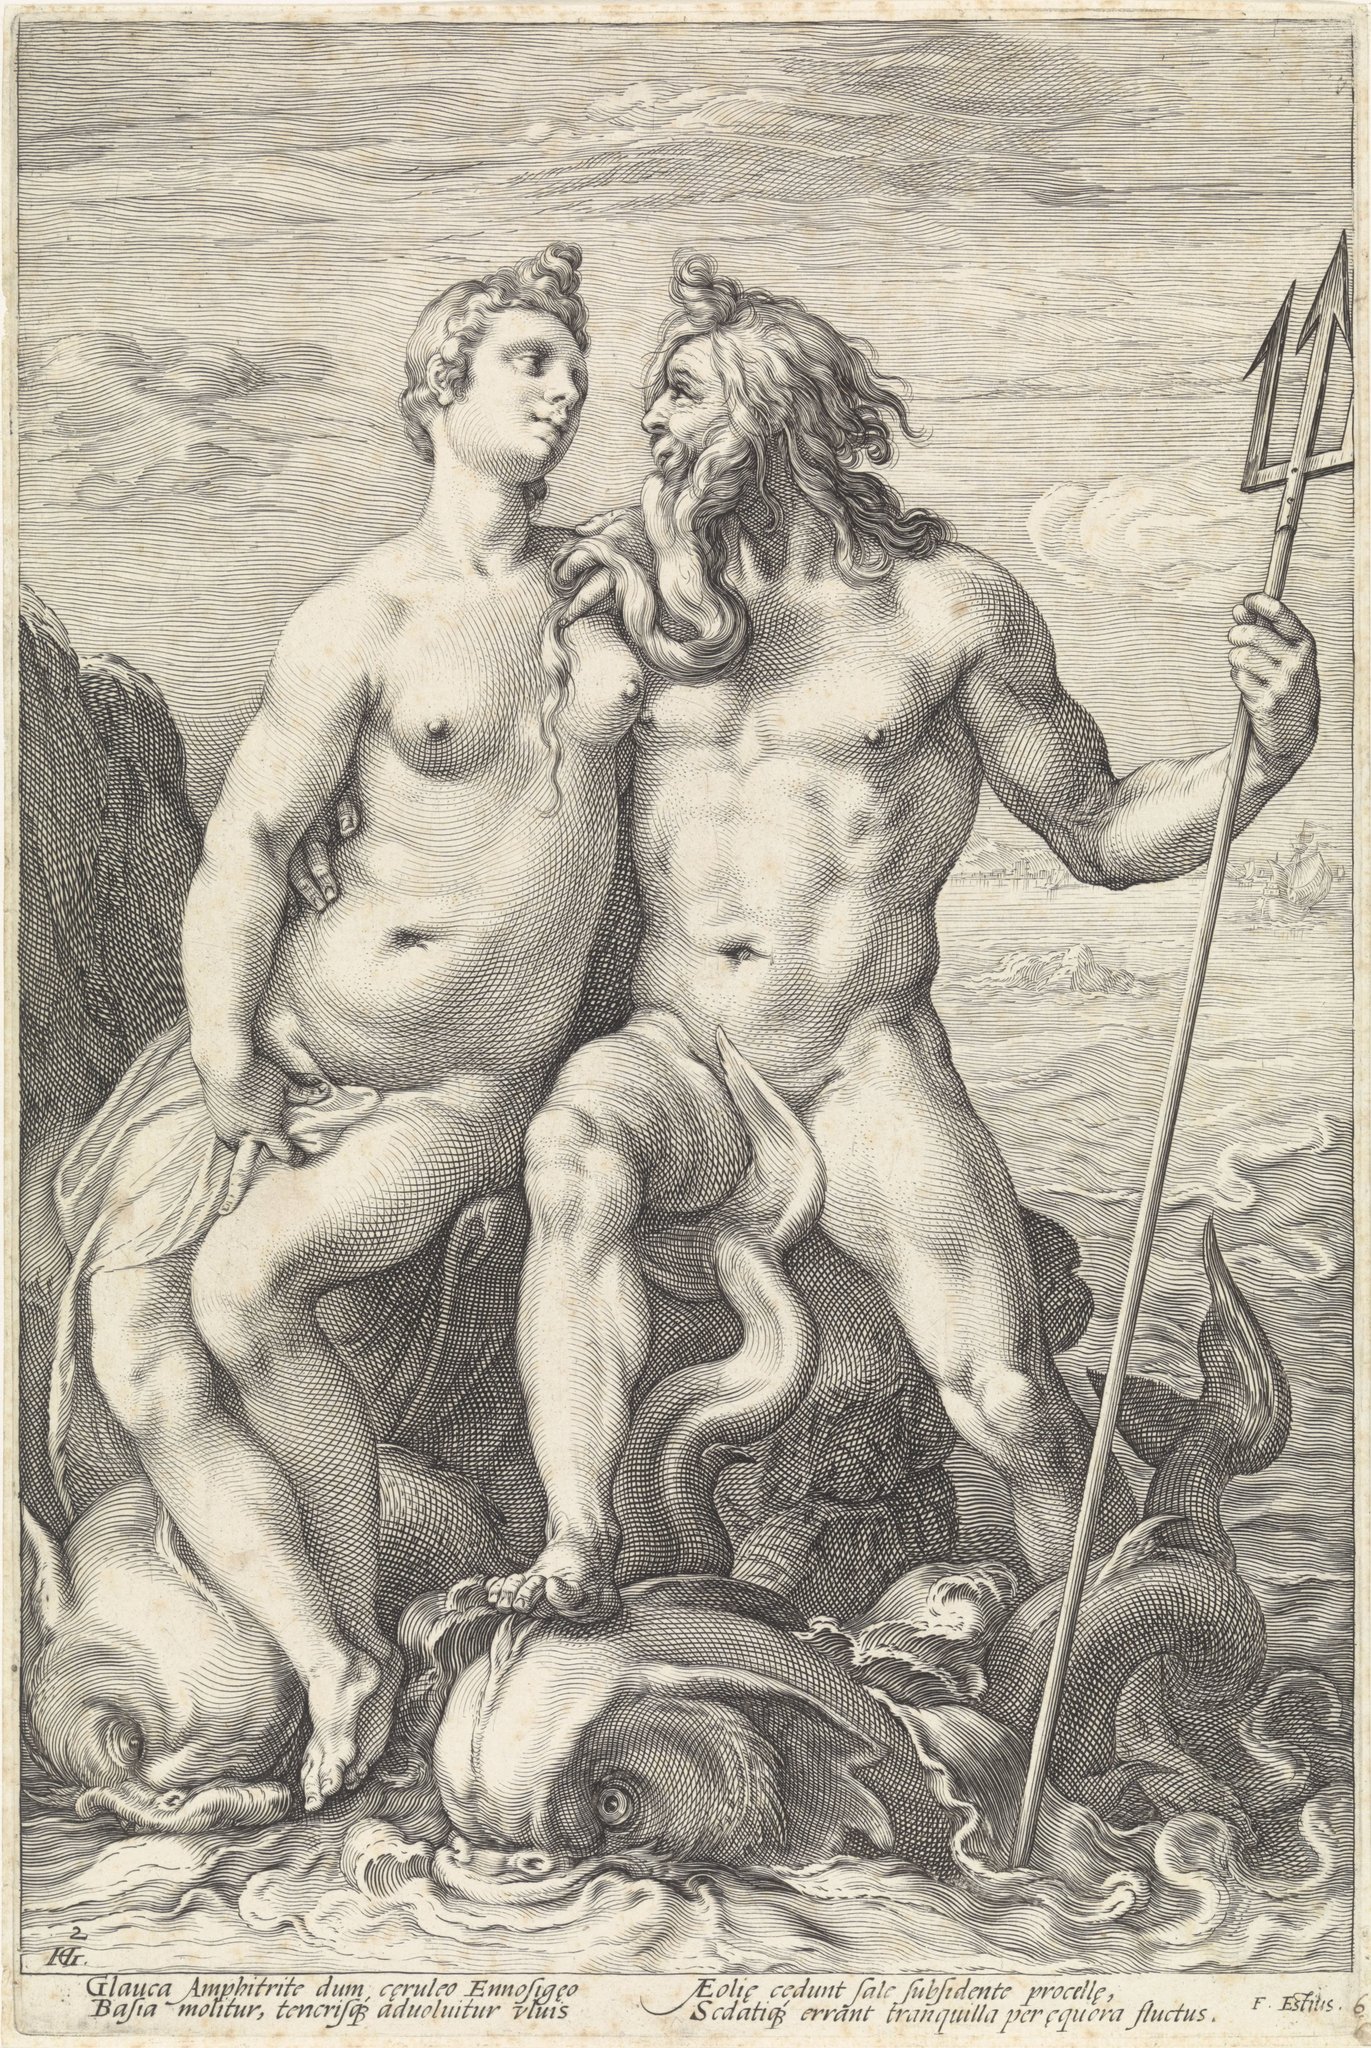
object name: print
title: Neptunus en Amphitrite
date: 1575-1607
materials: paper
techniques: engraving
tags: neptune in love with amphitrite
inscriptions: collector's mark: Lugt 10, number: ‘6’, collector's mark: Lugt 11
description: De naakte Neptunus en Amphitrite, rijdend op dolfijnen in de zee. Ze omhelzen elkaar. De prent is deel van een serie van godenparen en heeft een Latijns onderschrift.